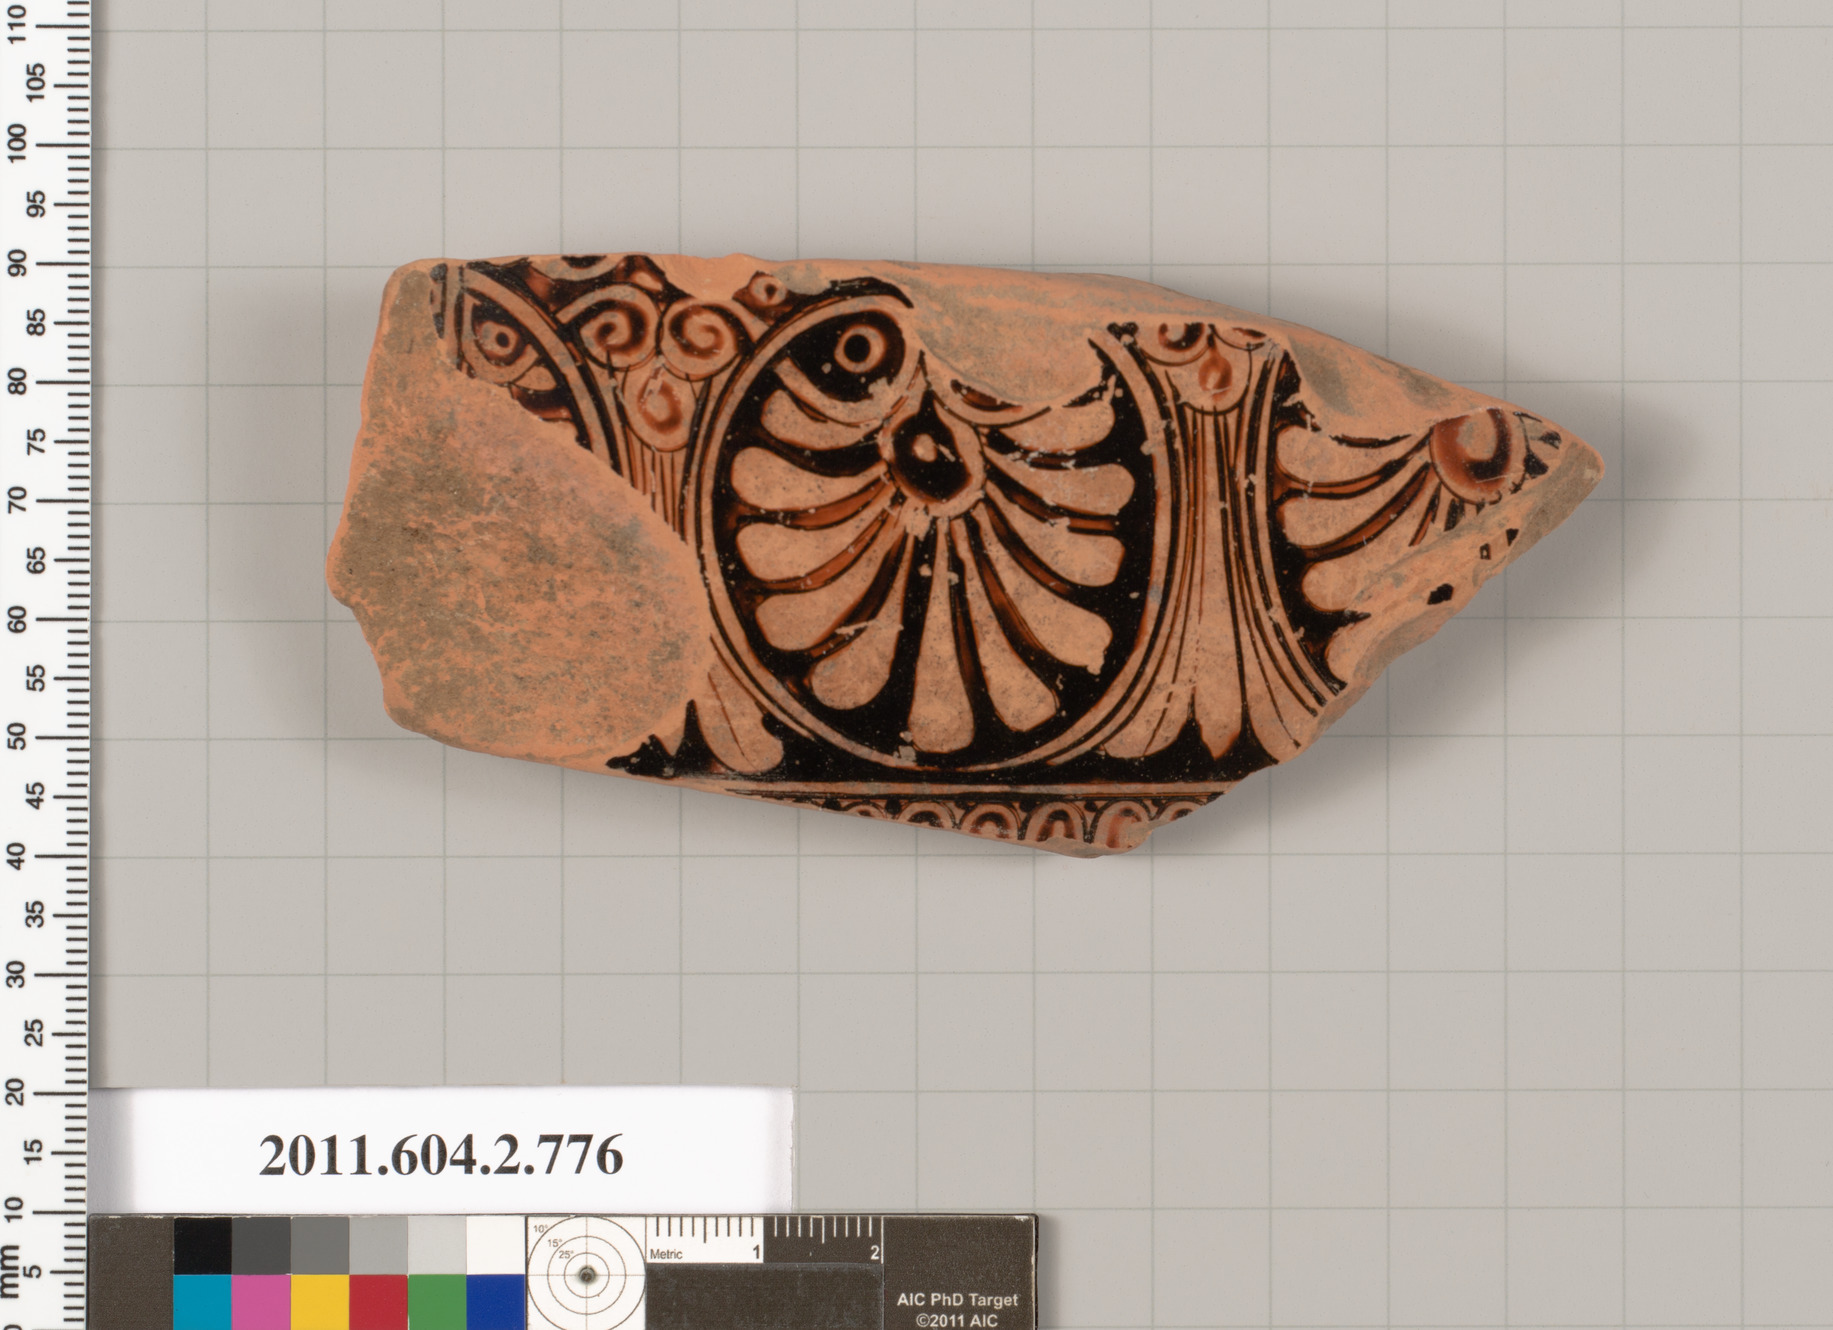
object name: calyx krater fragment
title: Terracotta fragment of a calyx-krater (bowl for mixing wine and water)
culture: greek, attic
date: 475-451 BCE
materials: terracotta